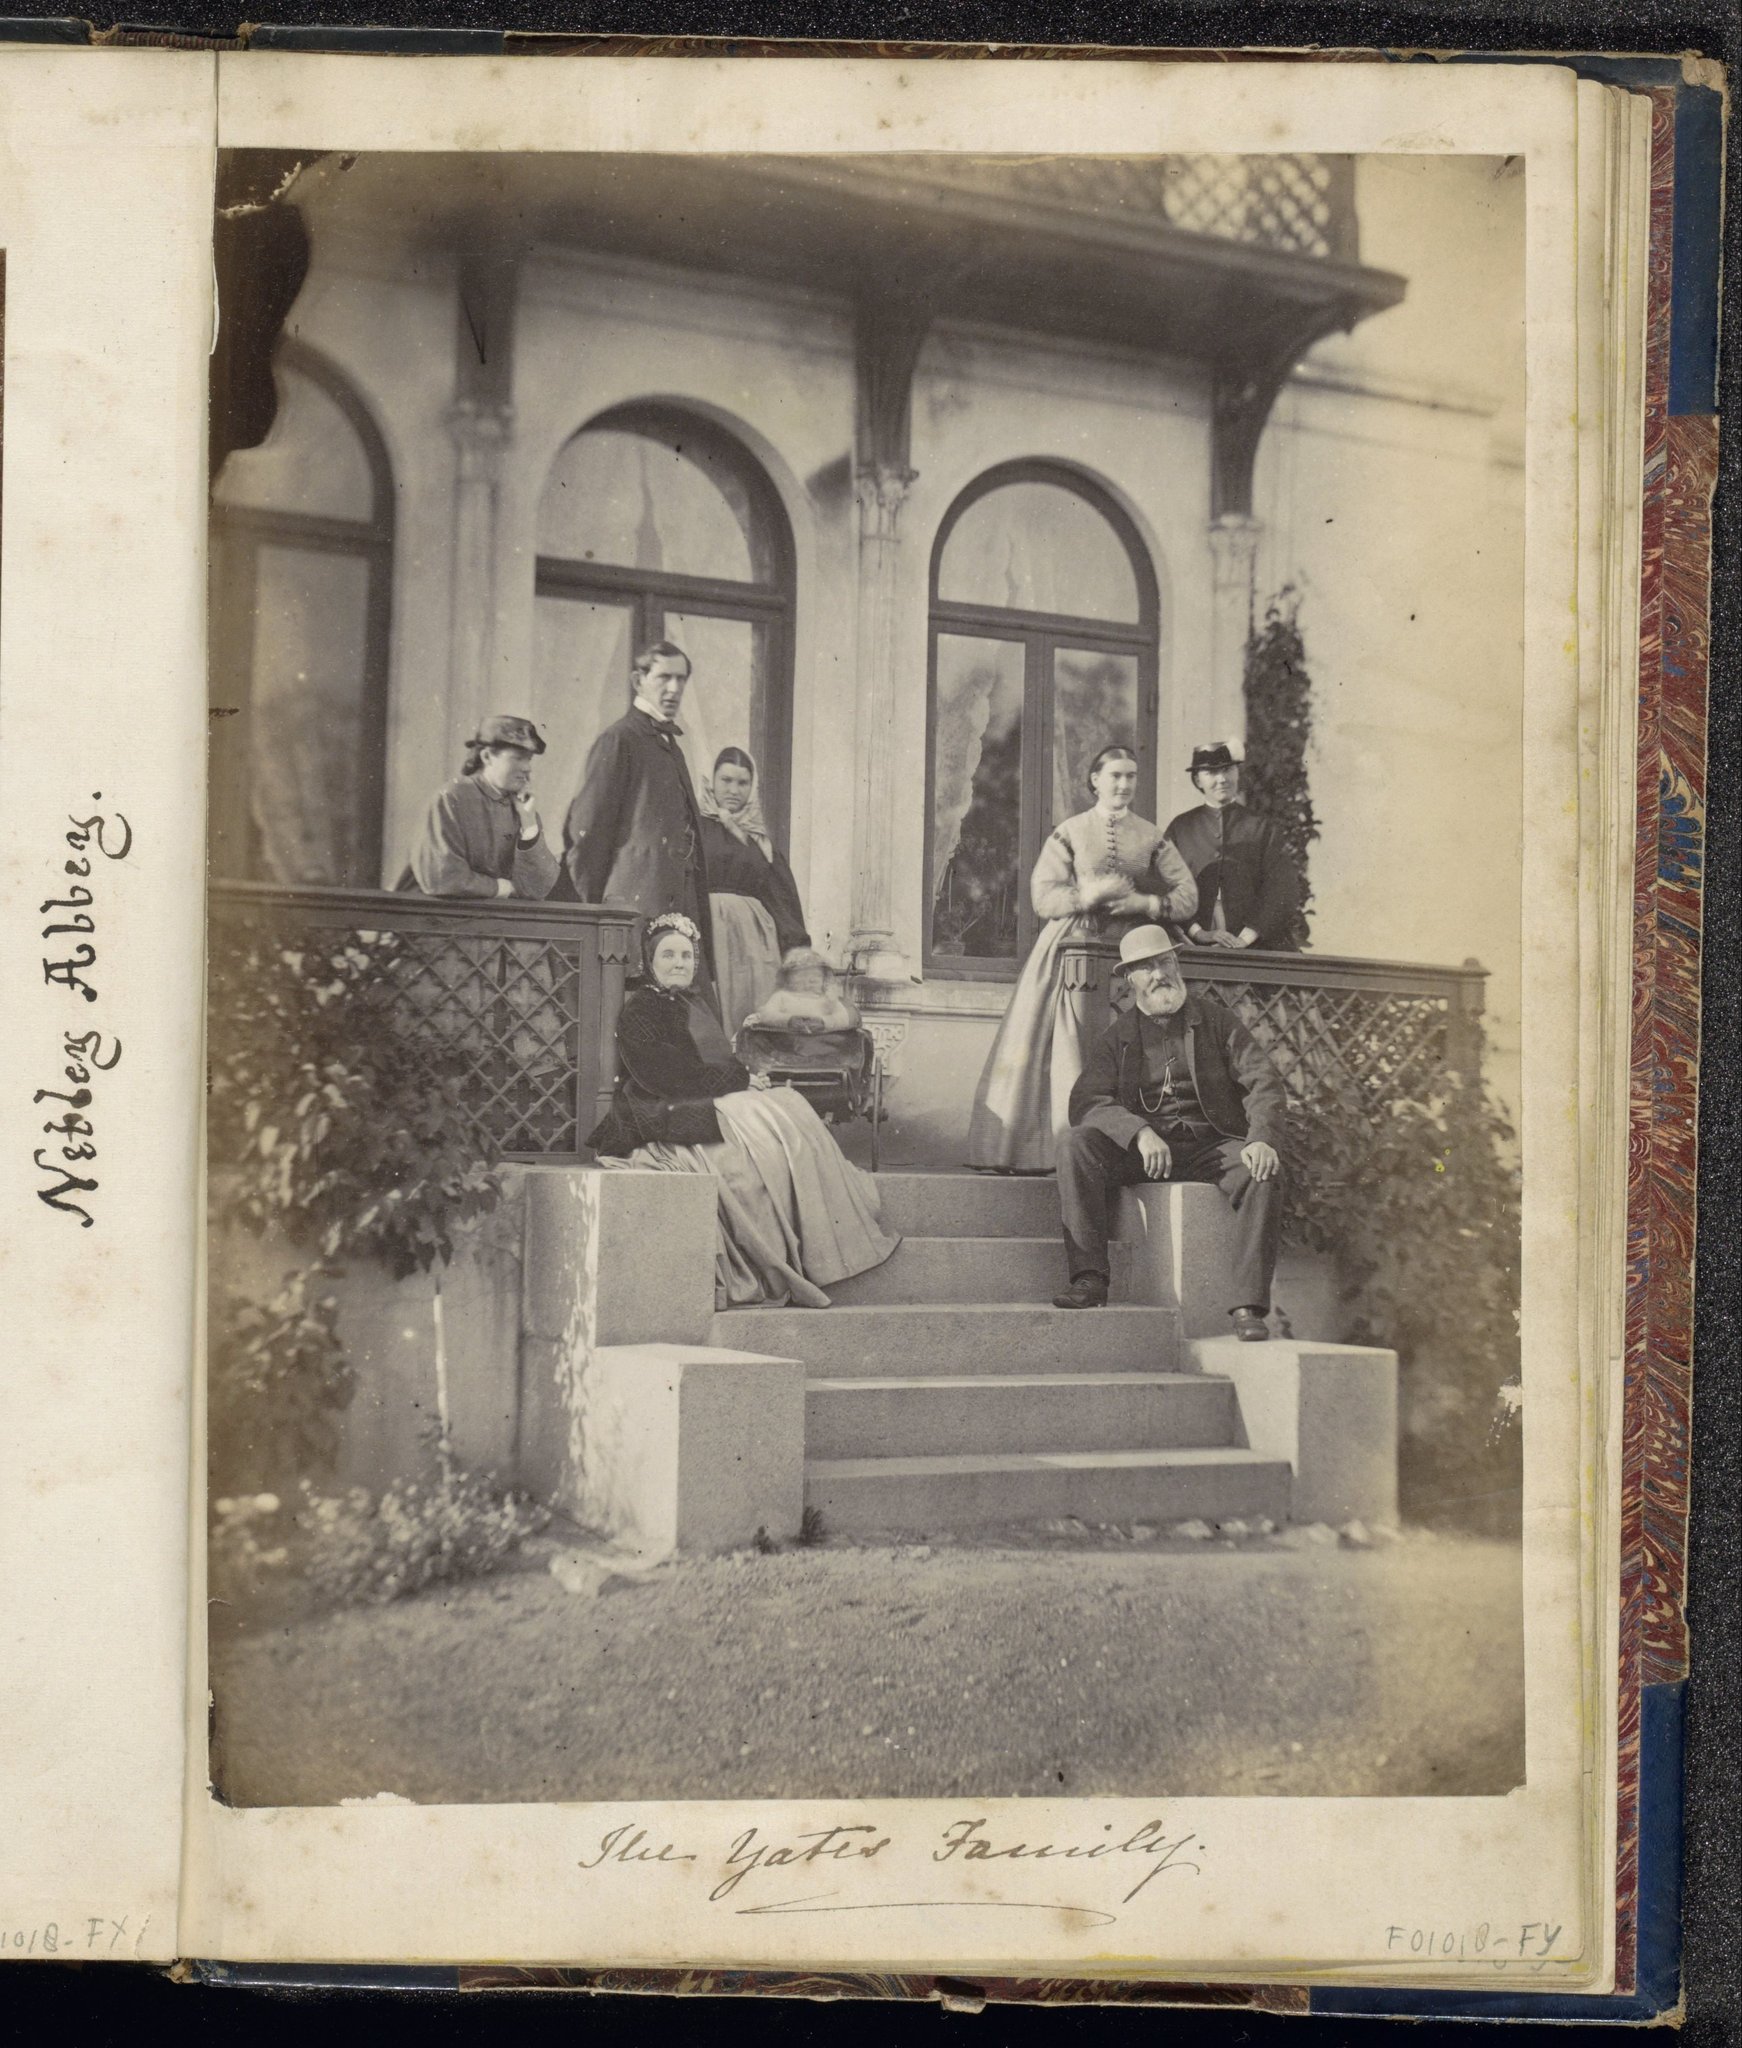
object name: photograph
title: The Yates Family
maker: Anonymous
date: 1860-1870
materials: paper, photographic support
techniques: albumen print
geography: christiania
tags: baby-carriage, pram, perambulator, head-gear, trousers, breeches, rural housing, e.g. country-house, villa, cottage, clothing for the upper part of the body, terrace, balcony, dress, gown, three generations (family group), beard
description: Onderdeel van Engels familiealbum met foto's van personen, reizen, cricket en kunstwerken.